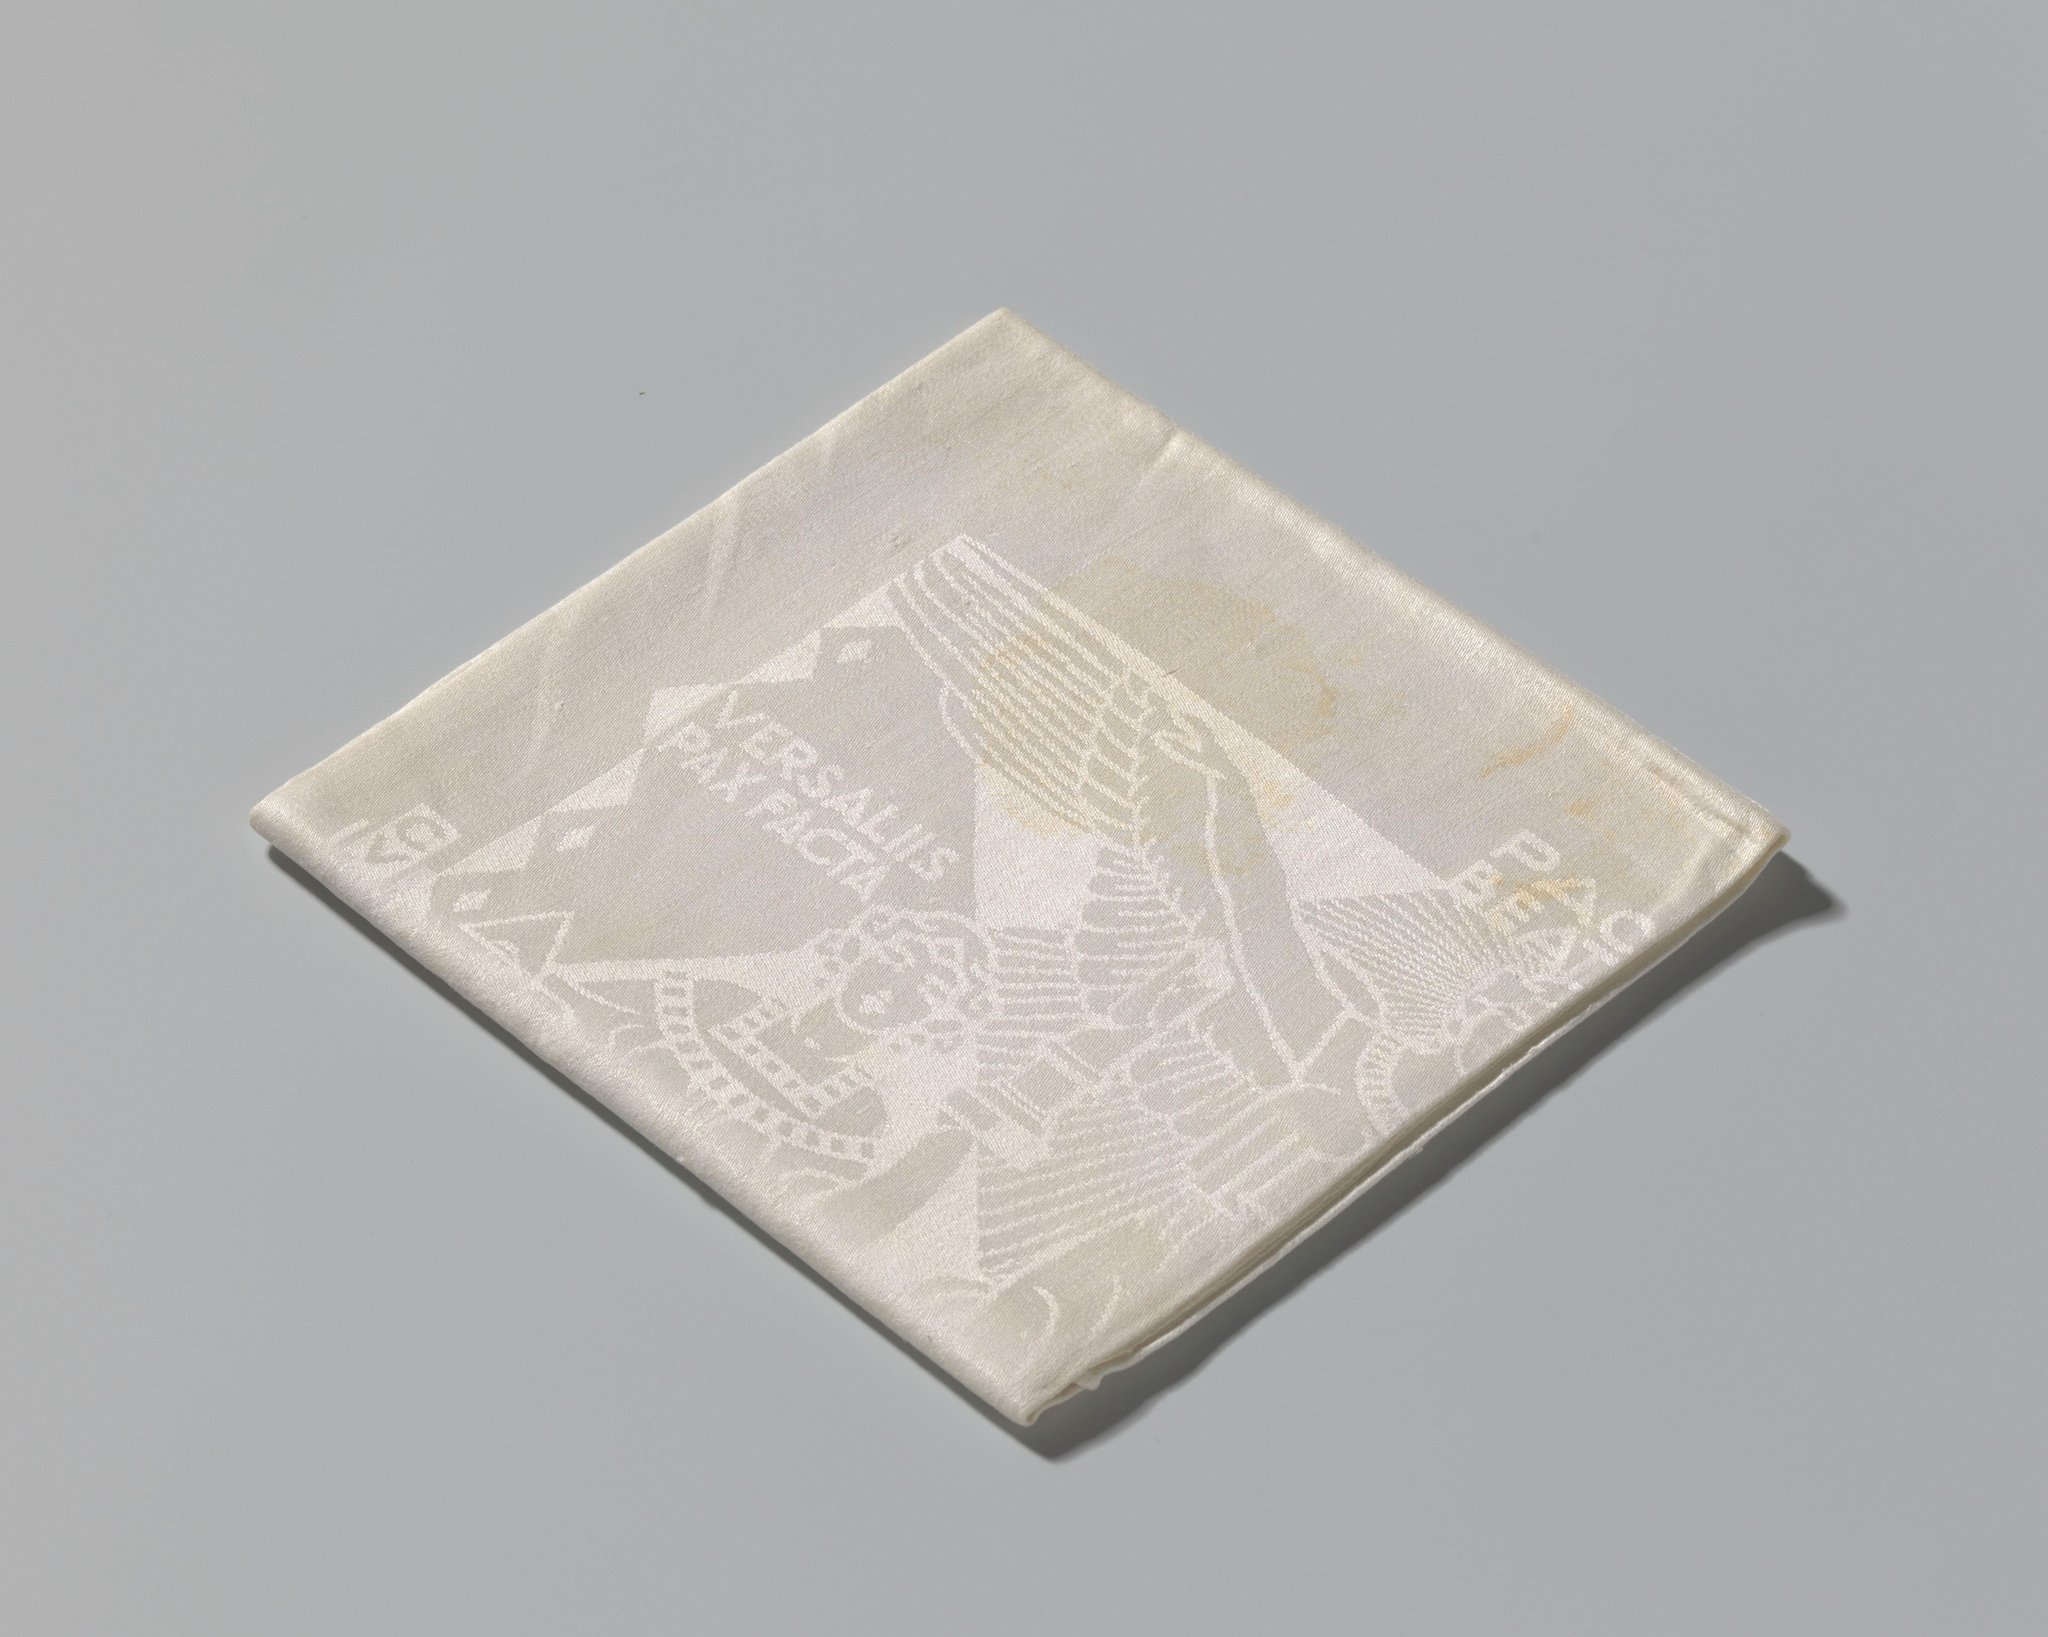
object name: napkin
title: Servet van wit linnendamast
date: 1919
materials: linen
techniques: damask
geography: netherlands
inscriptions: number: ‘558’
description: Wit linnen damasten servet met de Vrede van Versailles.